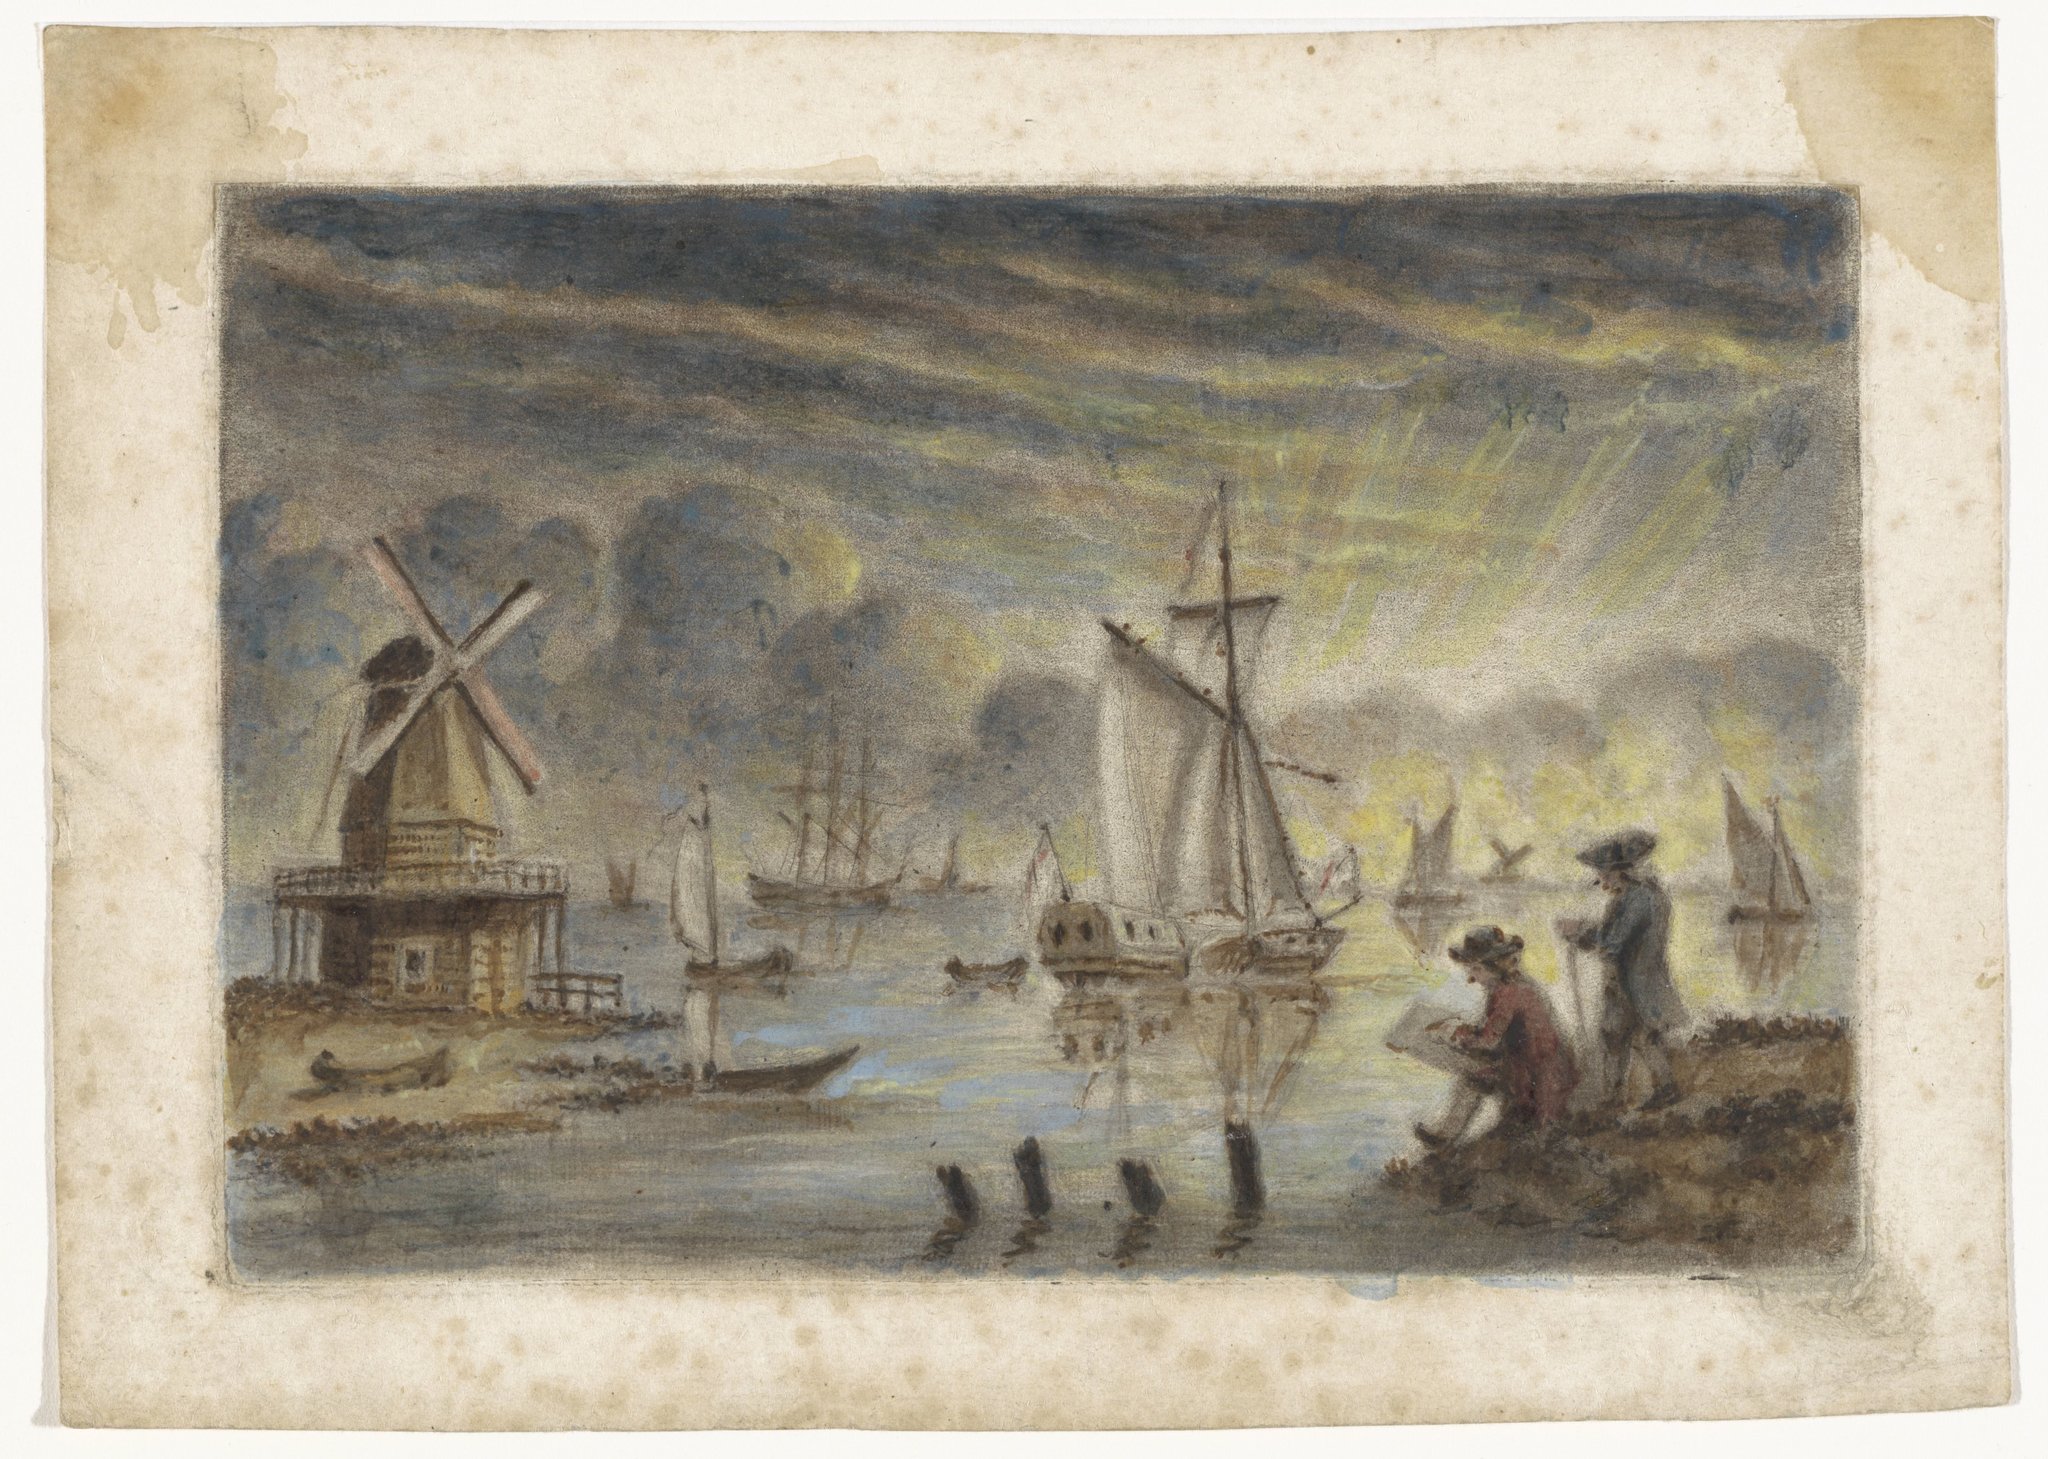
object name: print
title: Kustgezicht met schepen, molen en een tekenaar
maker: pieter louw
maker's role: draughtsman, print maker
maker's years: 1725-1800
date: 1735-1740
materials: paper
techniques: mezzotint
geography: amsterdam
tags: draughtsman at work - cc - out of doors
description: Kustgezicht met schepen, molen en een tekenaar. In de achtergrond een wolkenlucht met daarboven de zonnestralen.